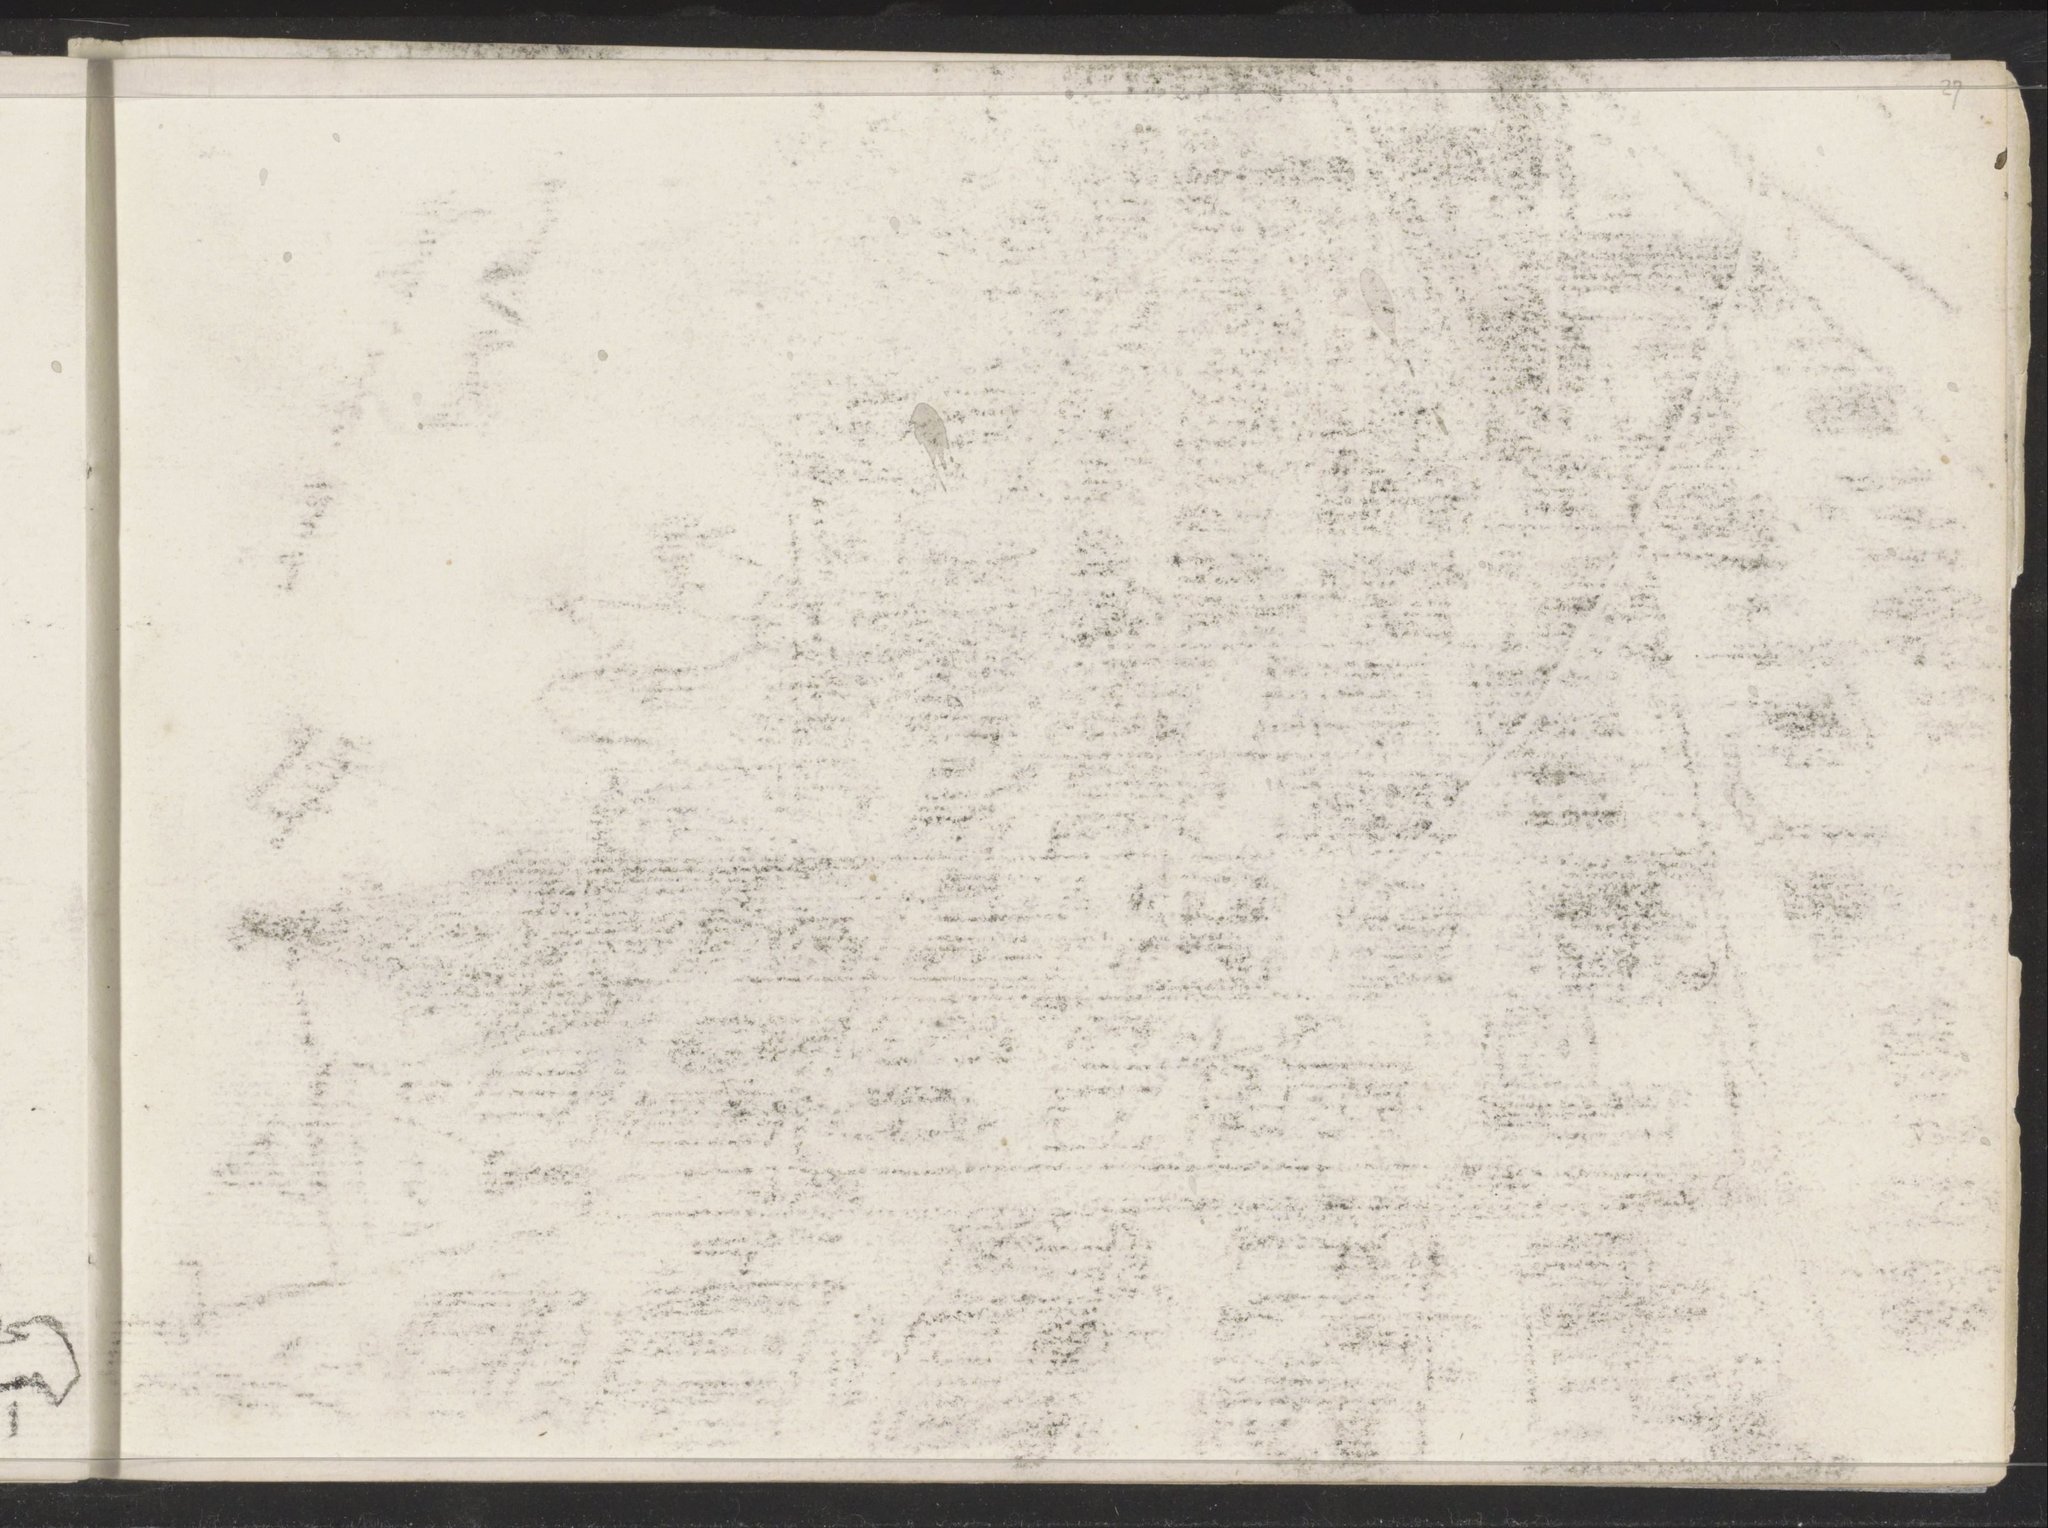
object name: sketchbook leaf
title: Abklatsch van de krijttekening op pagina 26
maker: willem witsen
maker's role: draughtsman, painter, print maker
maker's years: 1860-1923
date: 1897-1899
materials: paper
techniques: printmaking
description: Pagina 27 uit een schetsboek met 17 bladen.